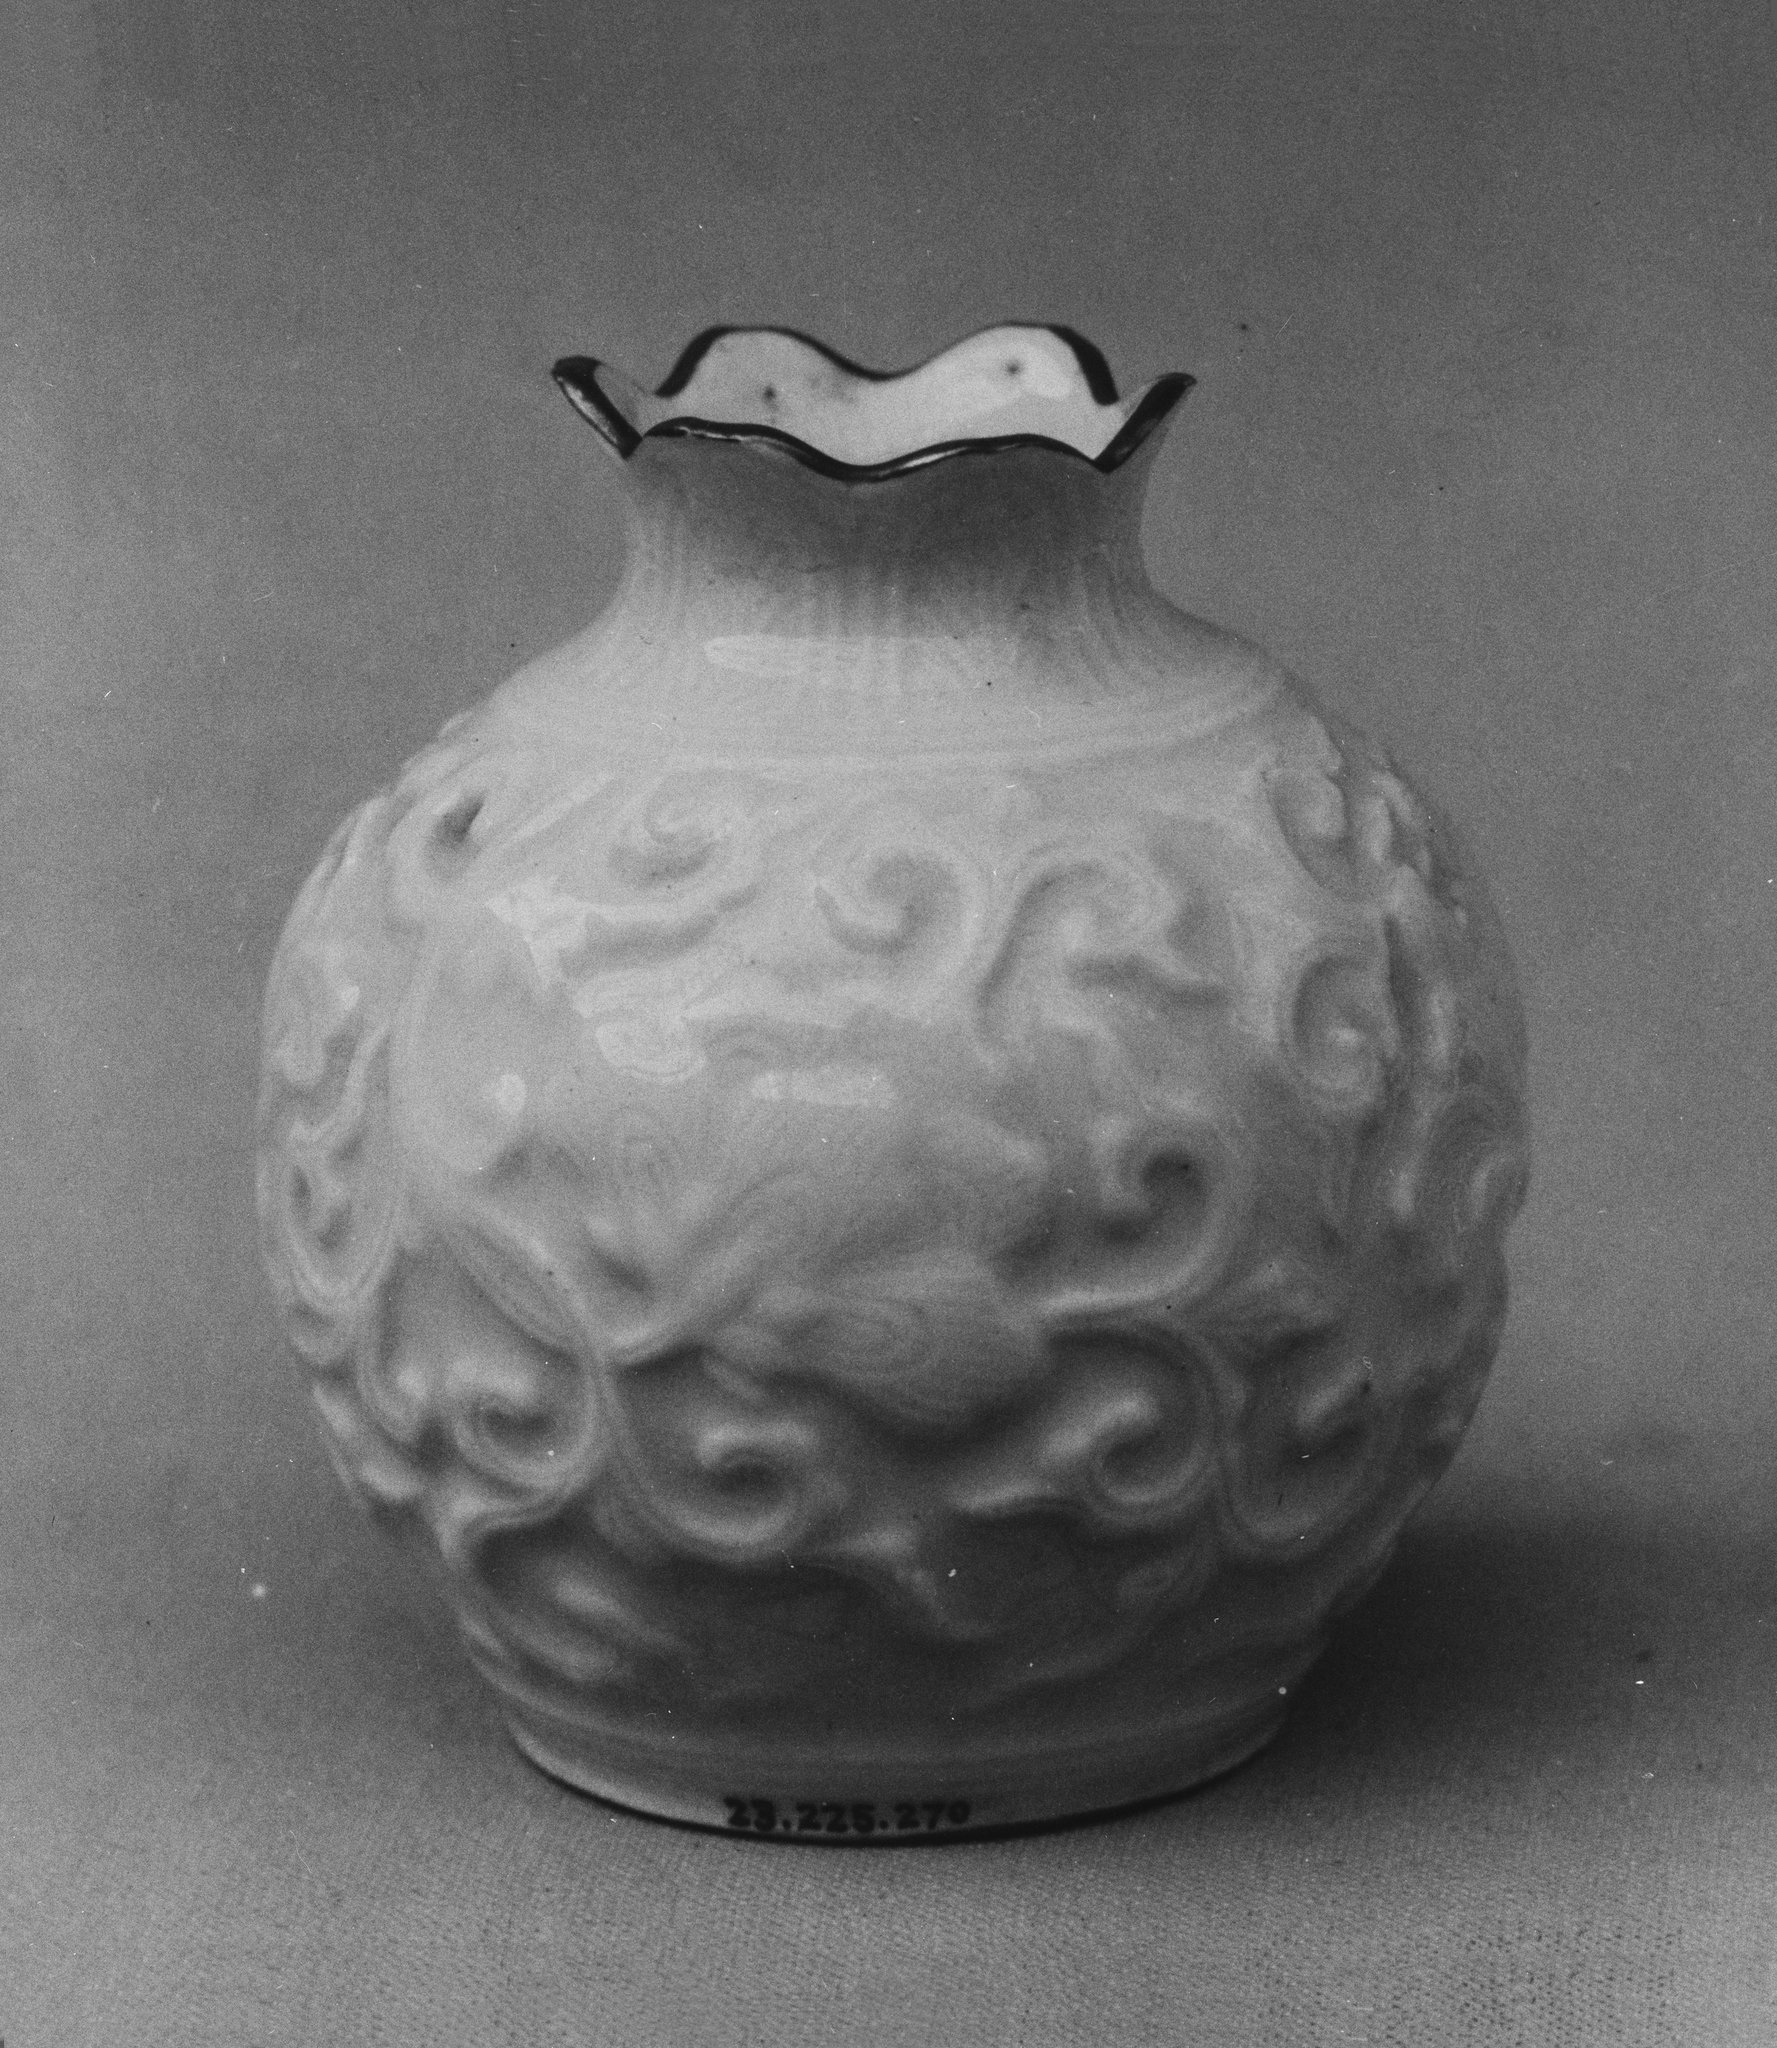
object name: vase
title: Bon-Bon Vase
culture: japanese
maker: eiraku hozen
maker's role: artist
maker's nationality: japanese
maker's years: 1795-1854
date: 1800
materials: glaze, porcelain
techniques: relief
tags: flowers